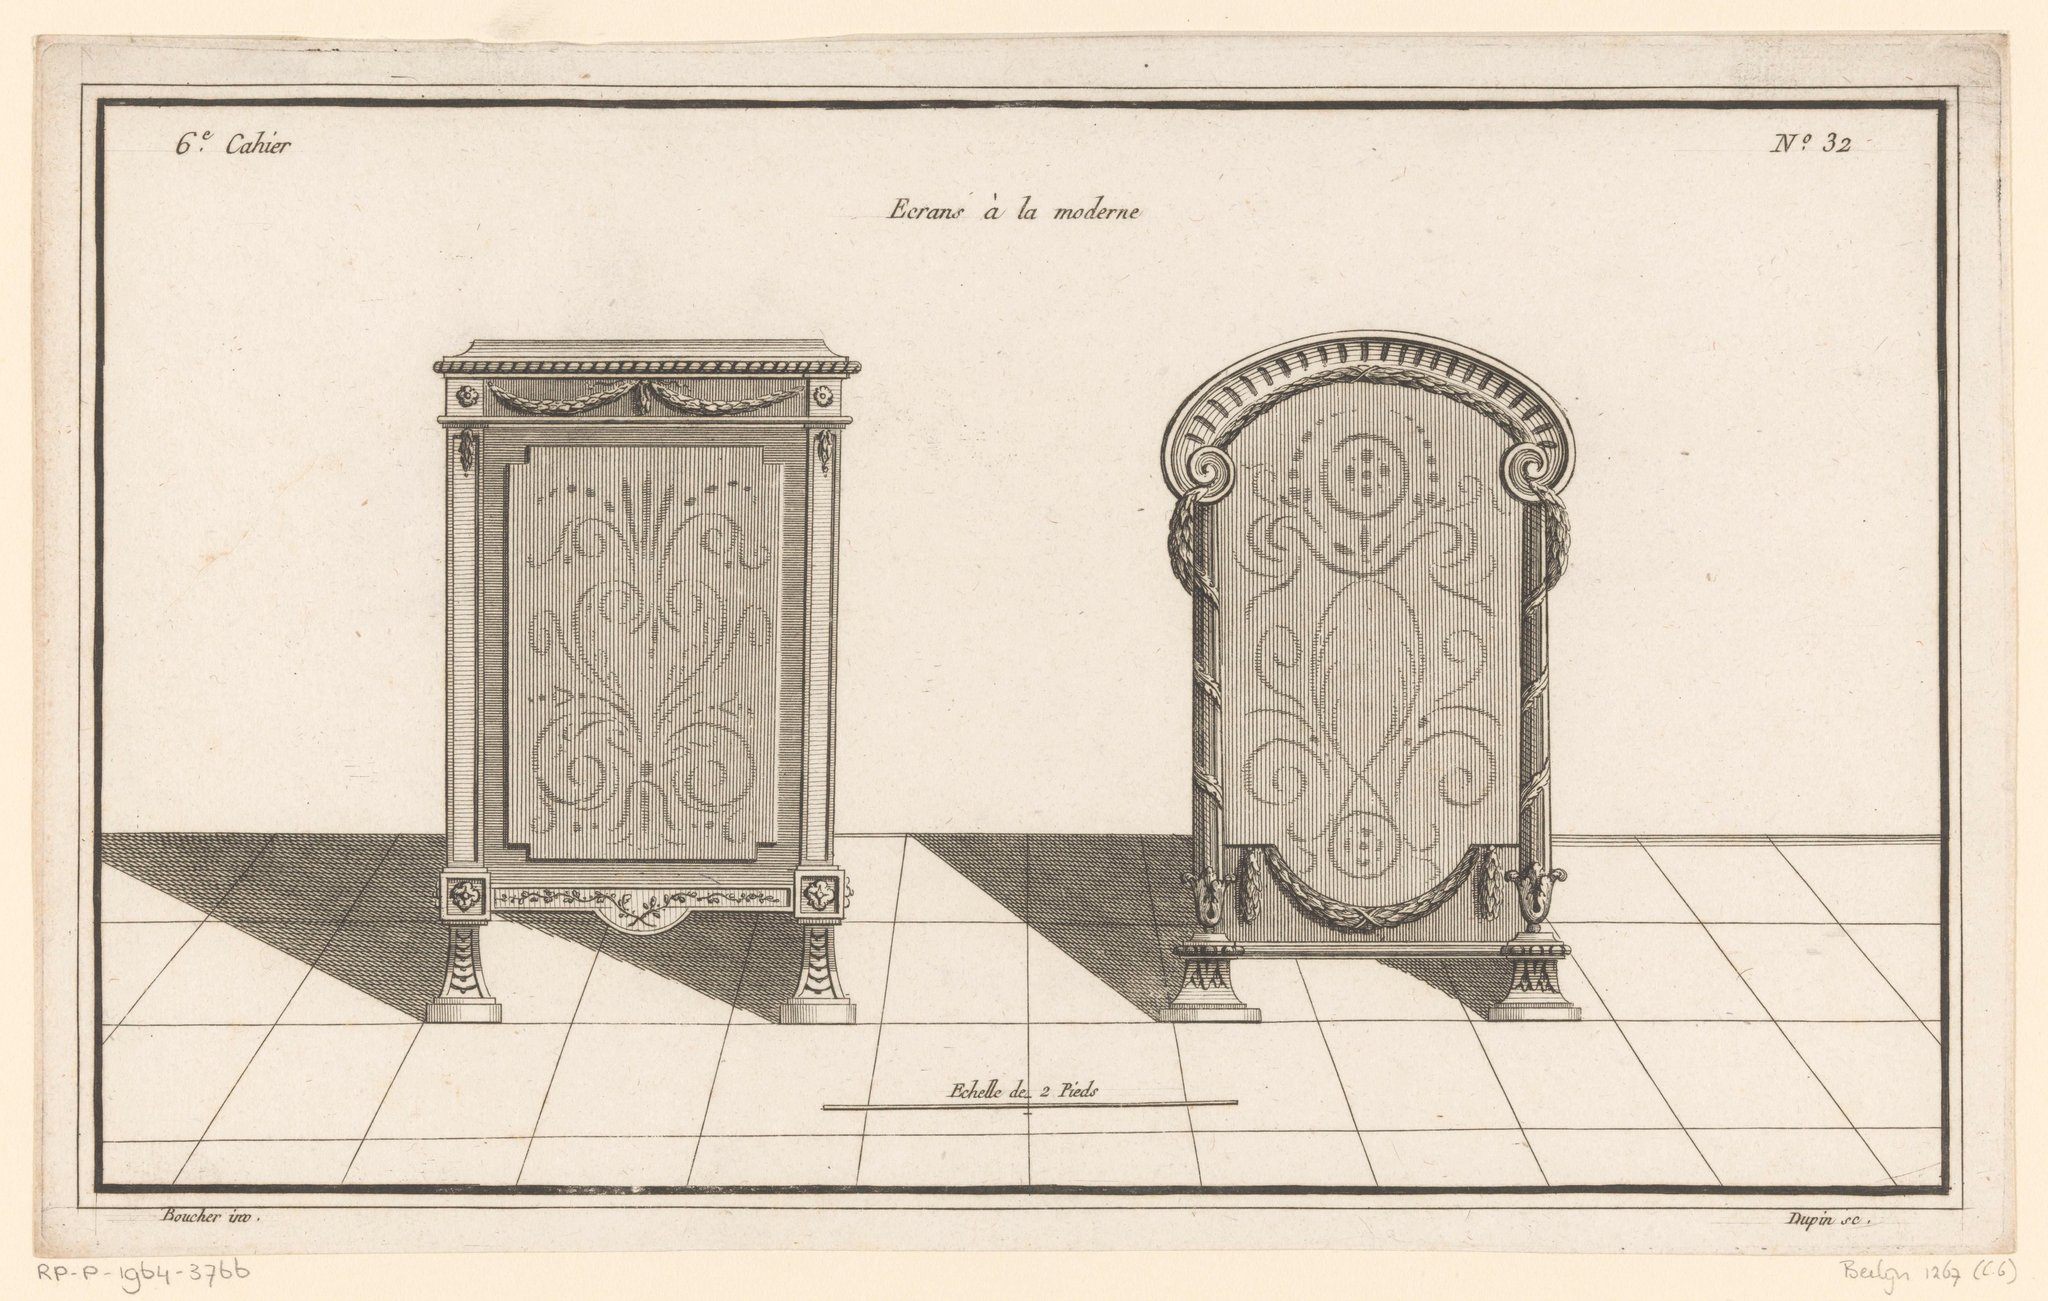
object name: print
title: Ecrans à la moderne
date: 1772-1779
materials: paper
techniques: engraving, etching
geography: paris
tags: fire-screen, ornament ~ festoon, garland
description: Twee geornamenteerde haardschermen met guirlandes. Prentnummer 32.